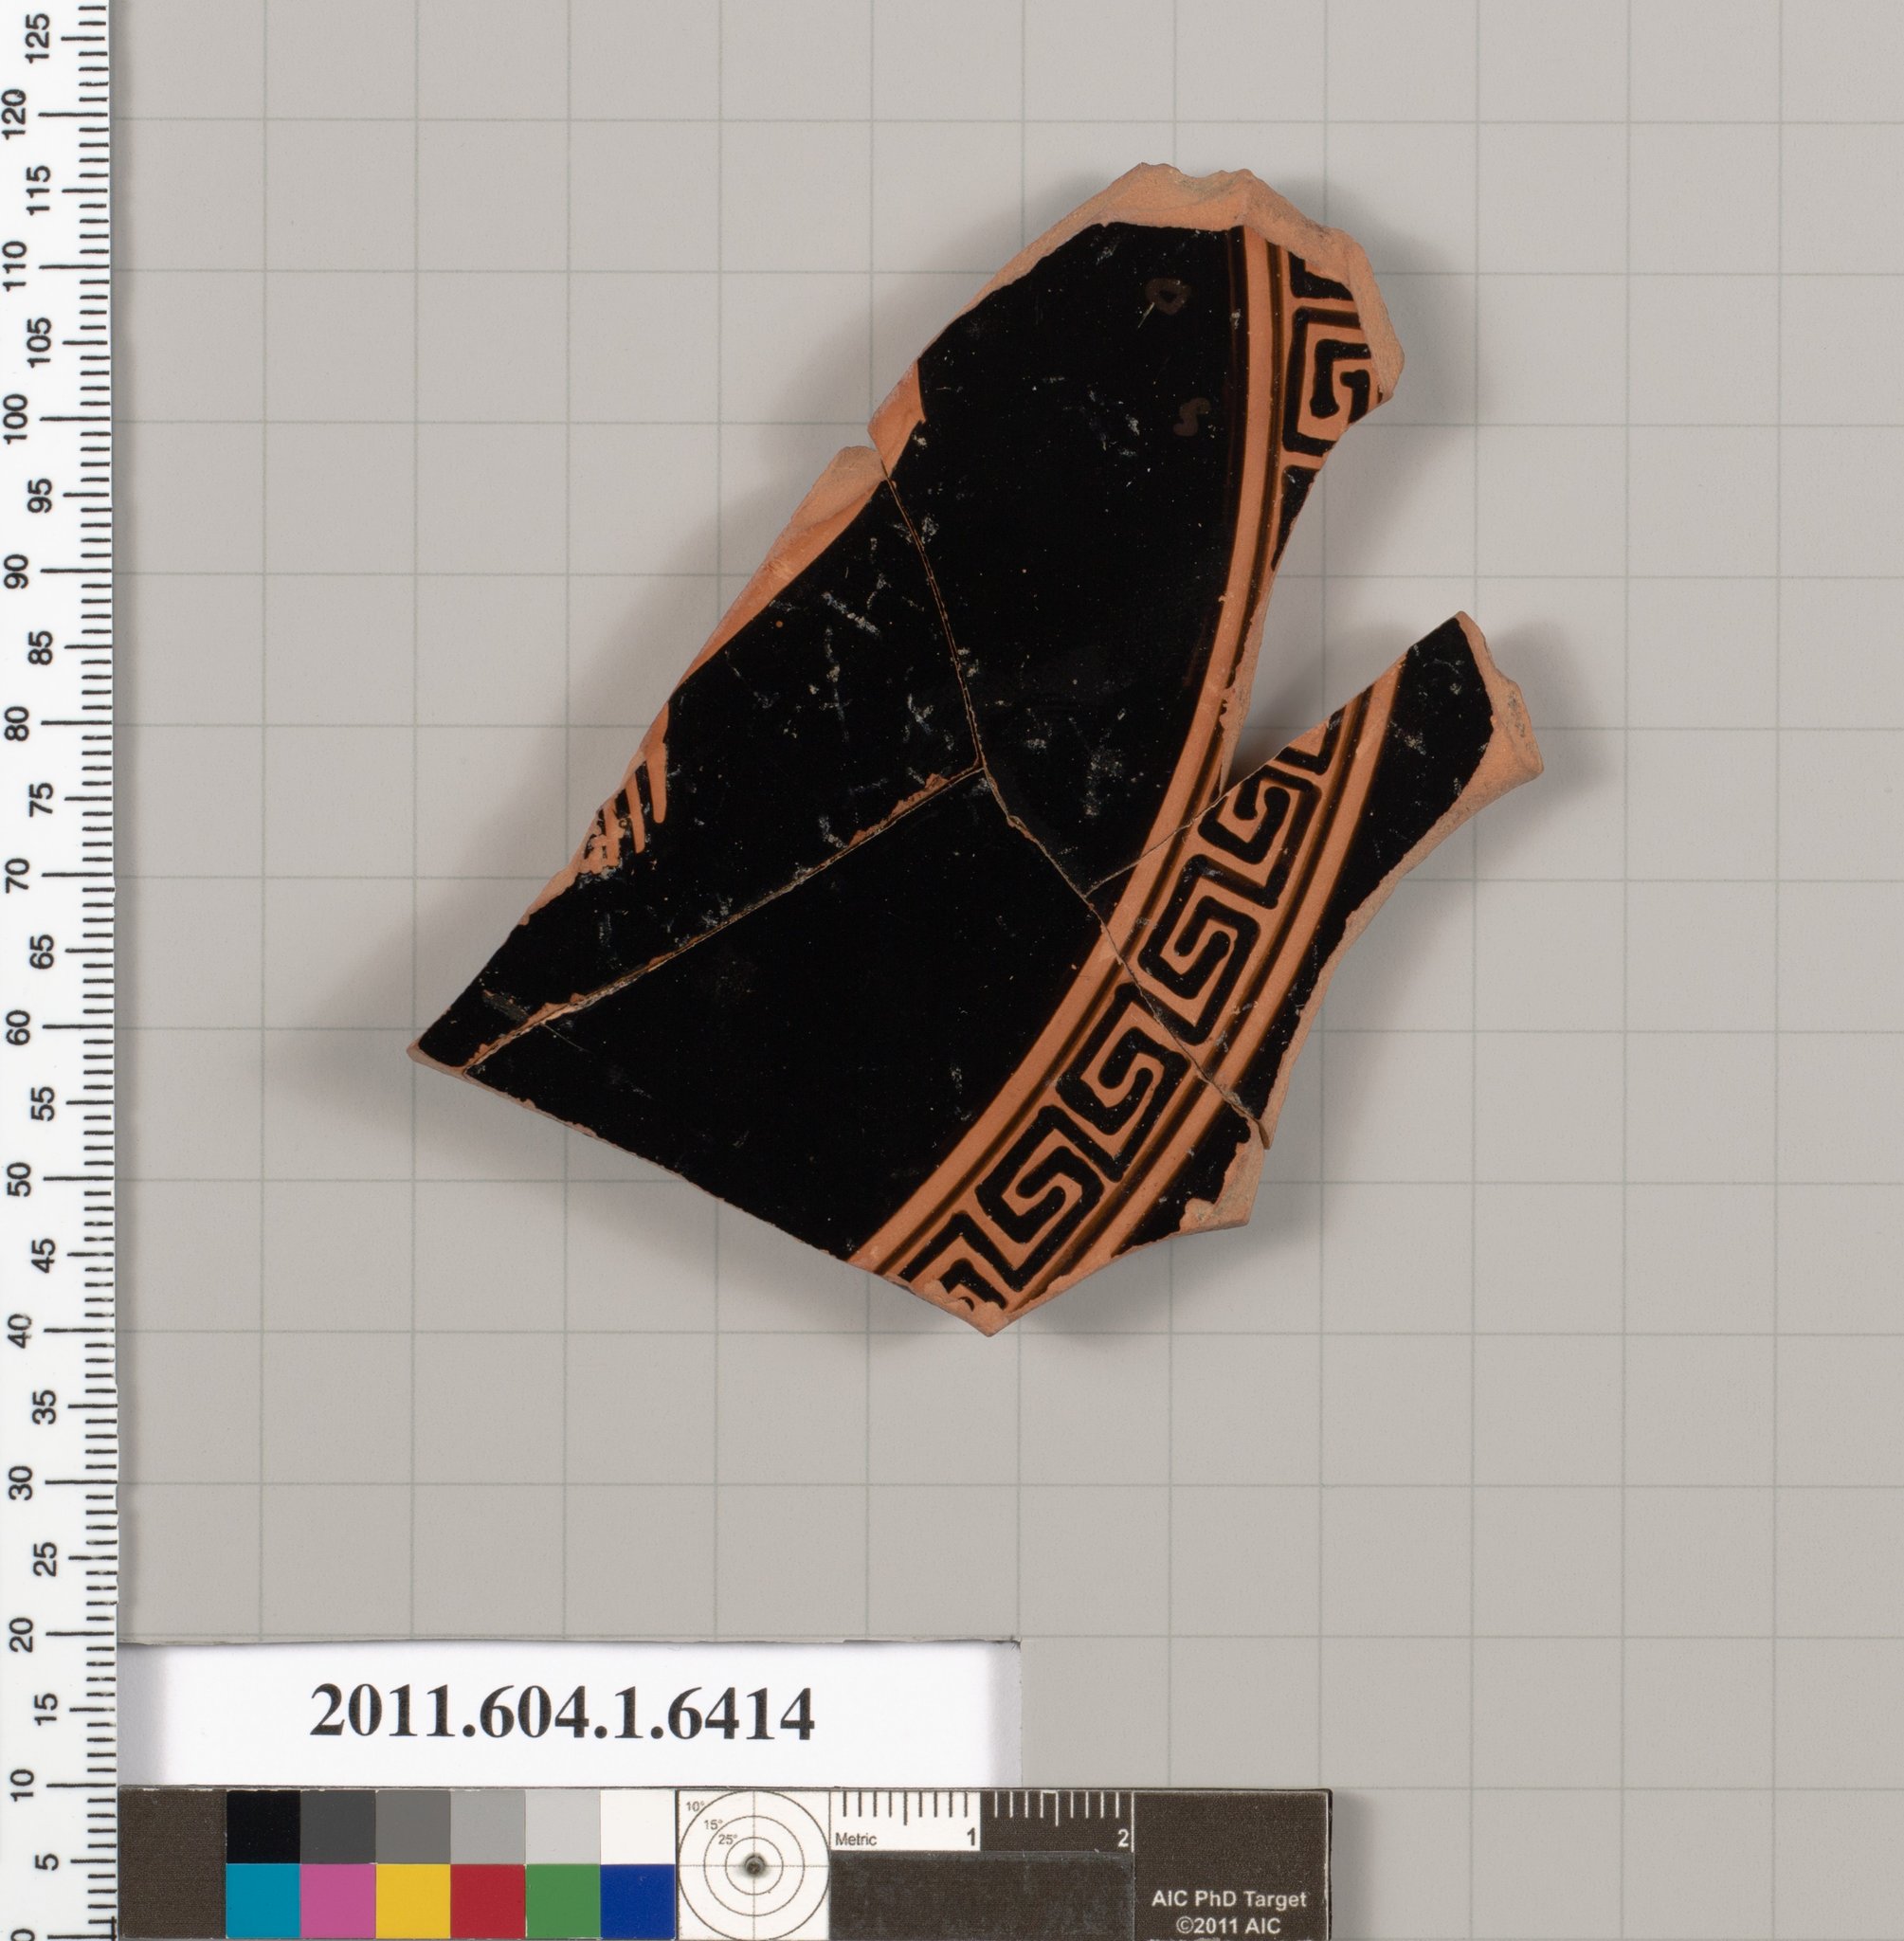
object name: kylix fragment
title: Terracotta fragment of a kylix (drinking cup)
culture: greek, attic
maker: antiphon painter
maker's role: artist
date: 490-480 BCE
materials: terracotta